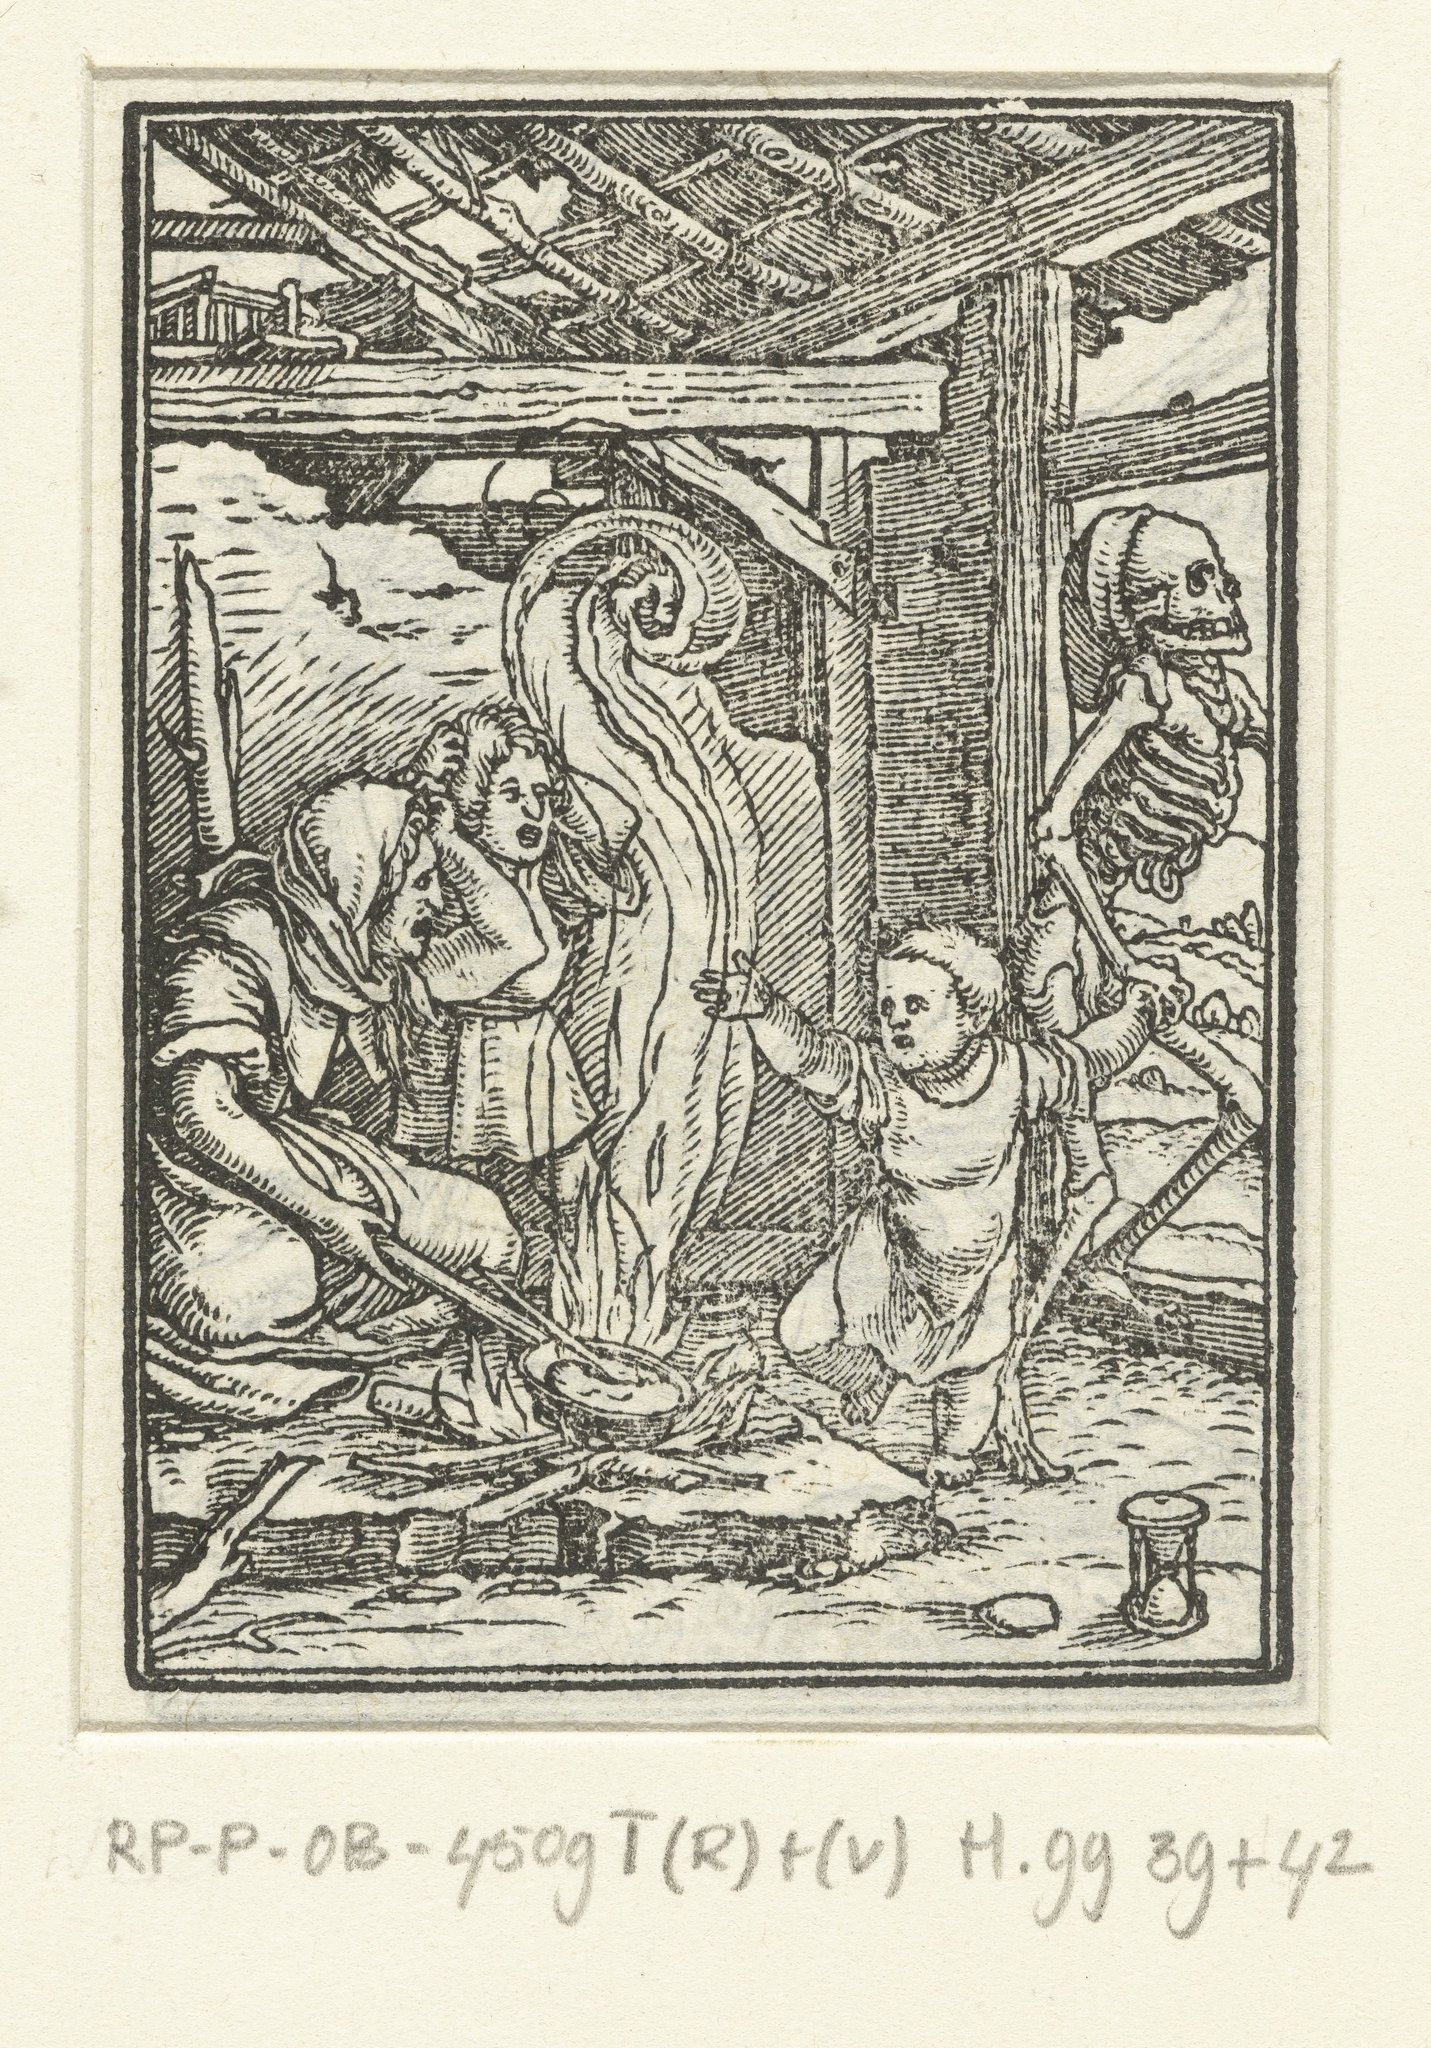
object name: book illustration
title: Dodendans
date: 1524-1526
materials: paper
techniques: woodcut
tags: child, dance of death; death together with one or more human beings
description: De houtblokken werden voor 1526 vervaardigd door Hans Lützelburg en pas in 1538 voor het eerst gebruikt als boekillustraties in: Les simulachres & historiees faces de la mort avtant elegamment pourtraictes que artificiellement imaginées... a Lyon, Soubsz l'escu de Coloigne, MDXXXVIII, (M. en G. Trechsel, voor F. Frellon in Lyon), 1538. Later verschenen nog andere uitgaven.